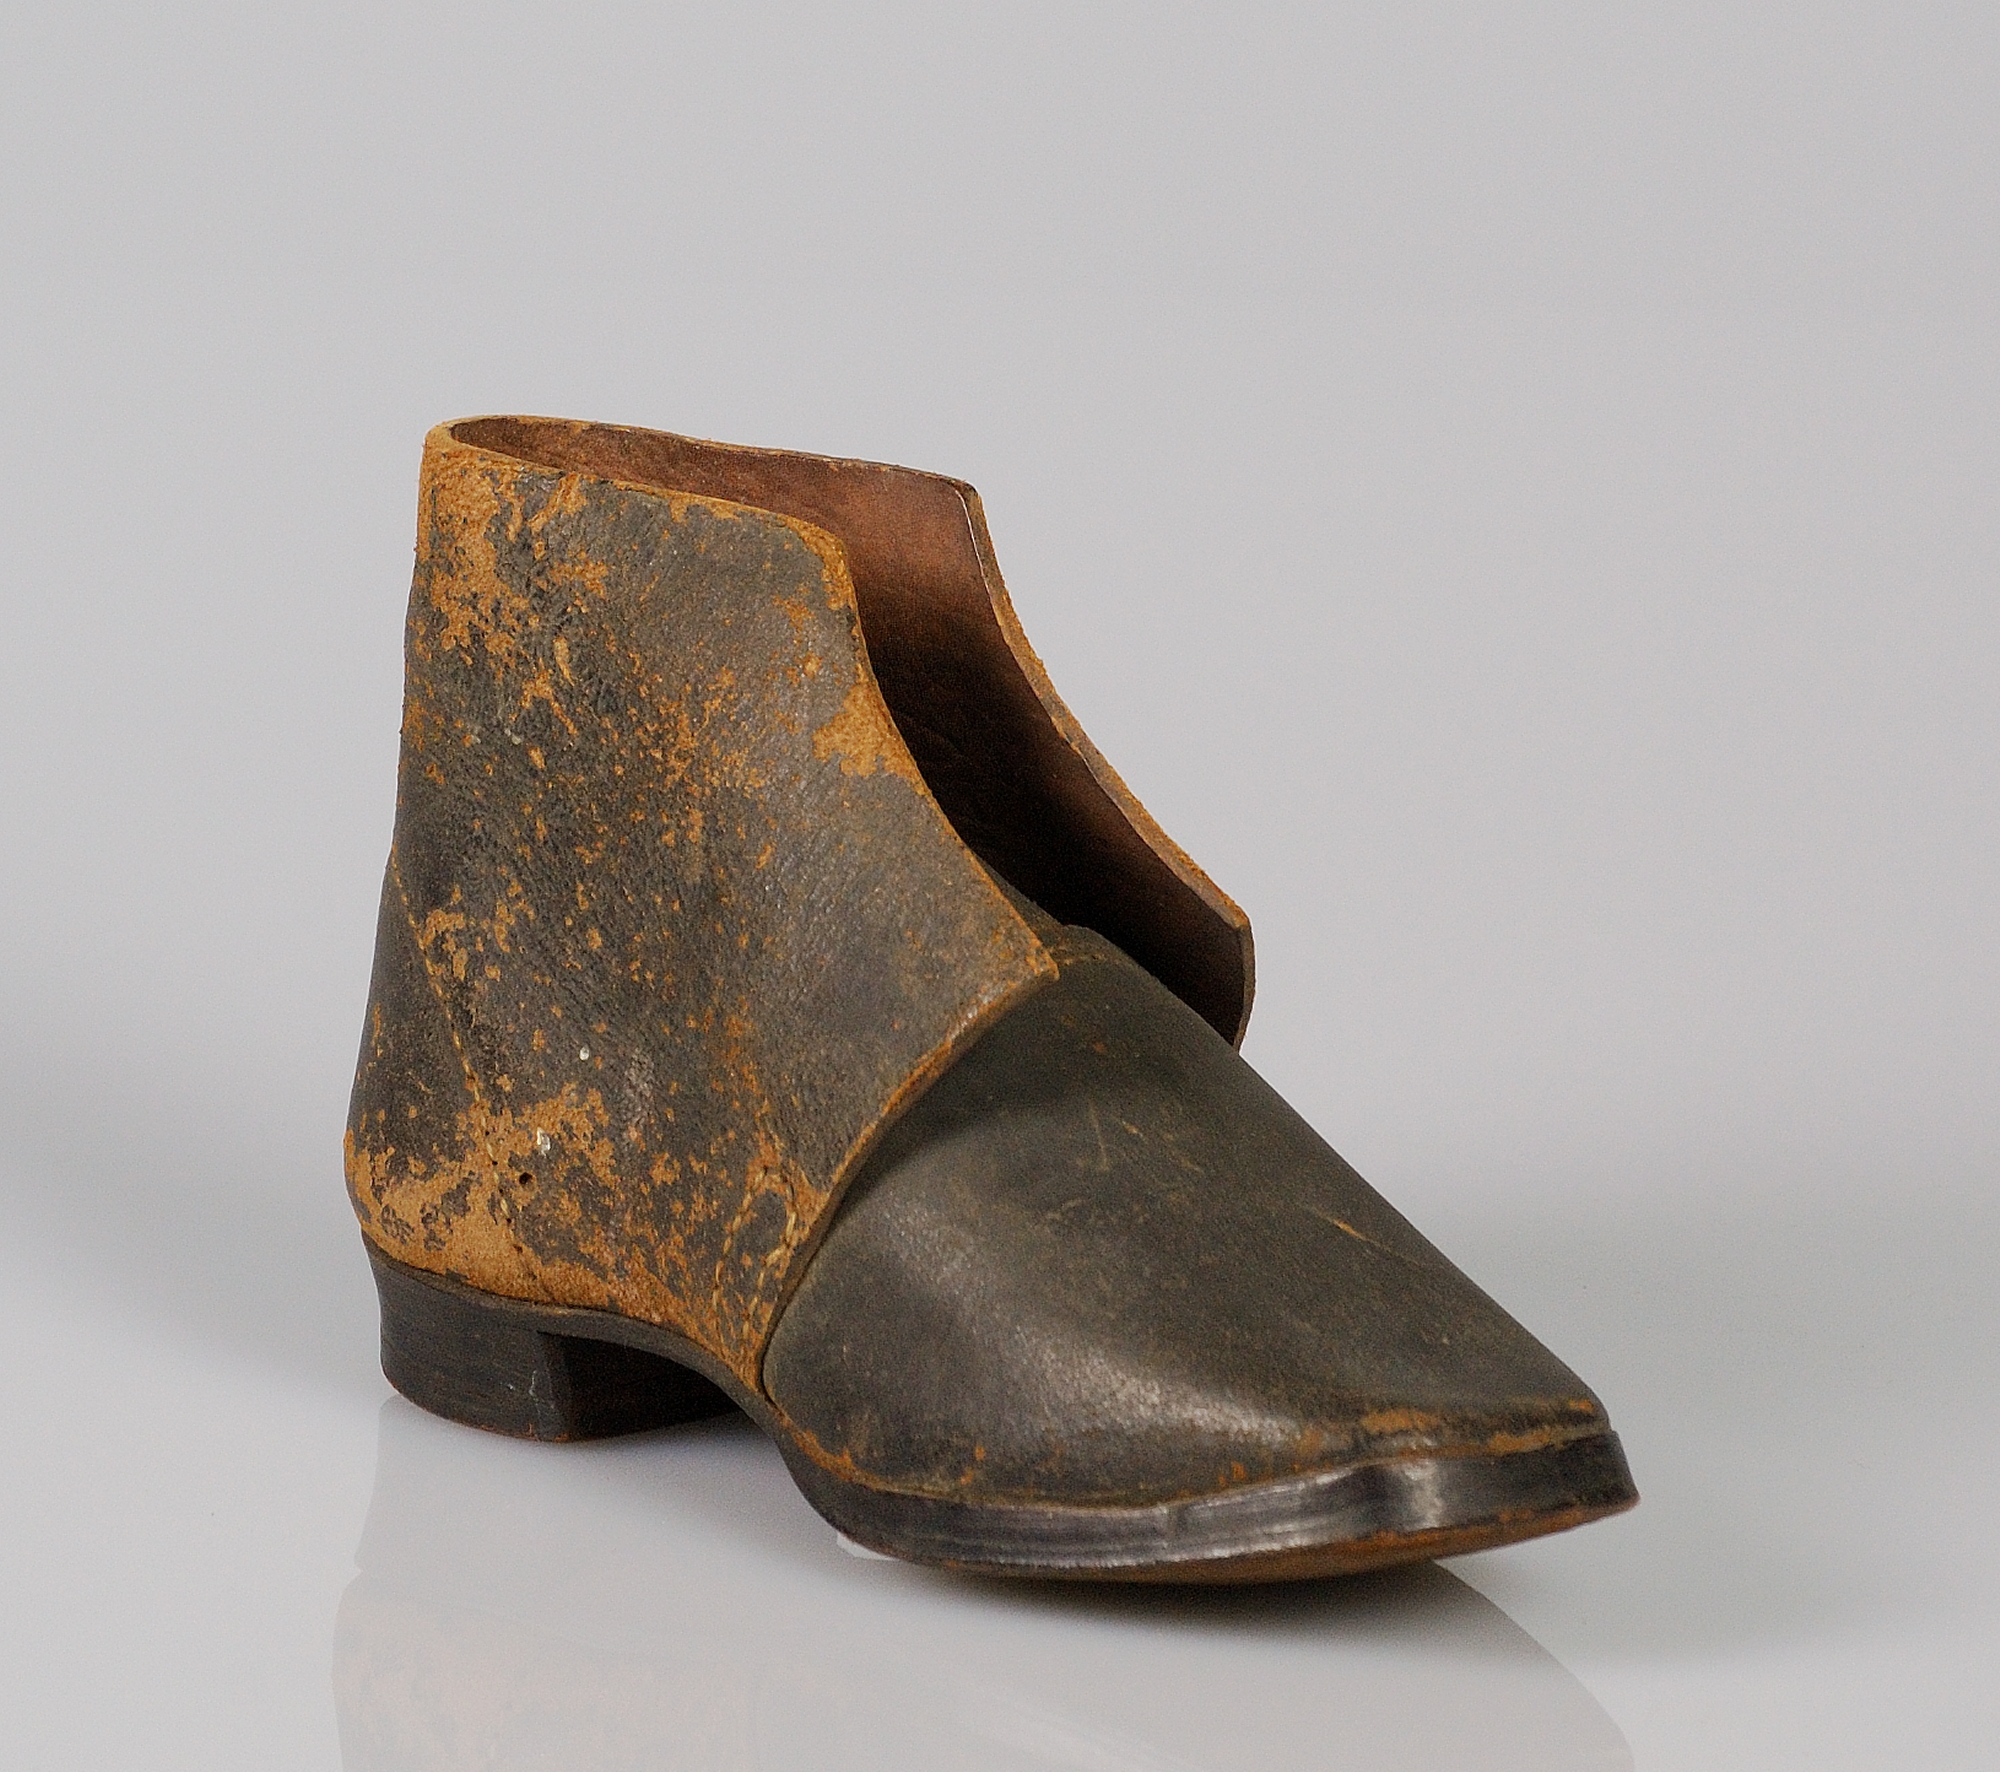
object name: brogan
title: Brogans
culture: american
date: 1851-1875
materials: leather